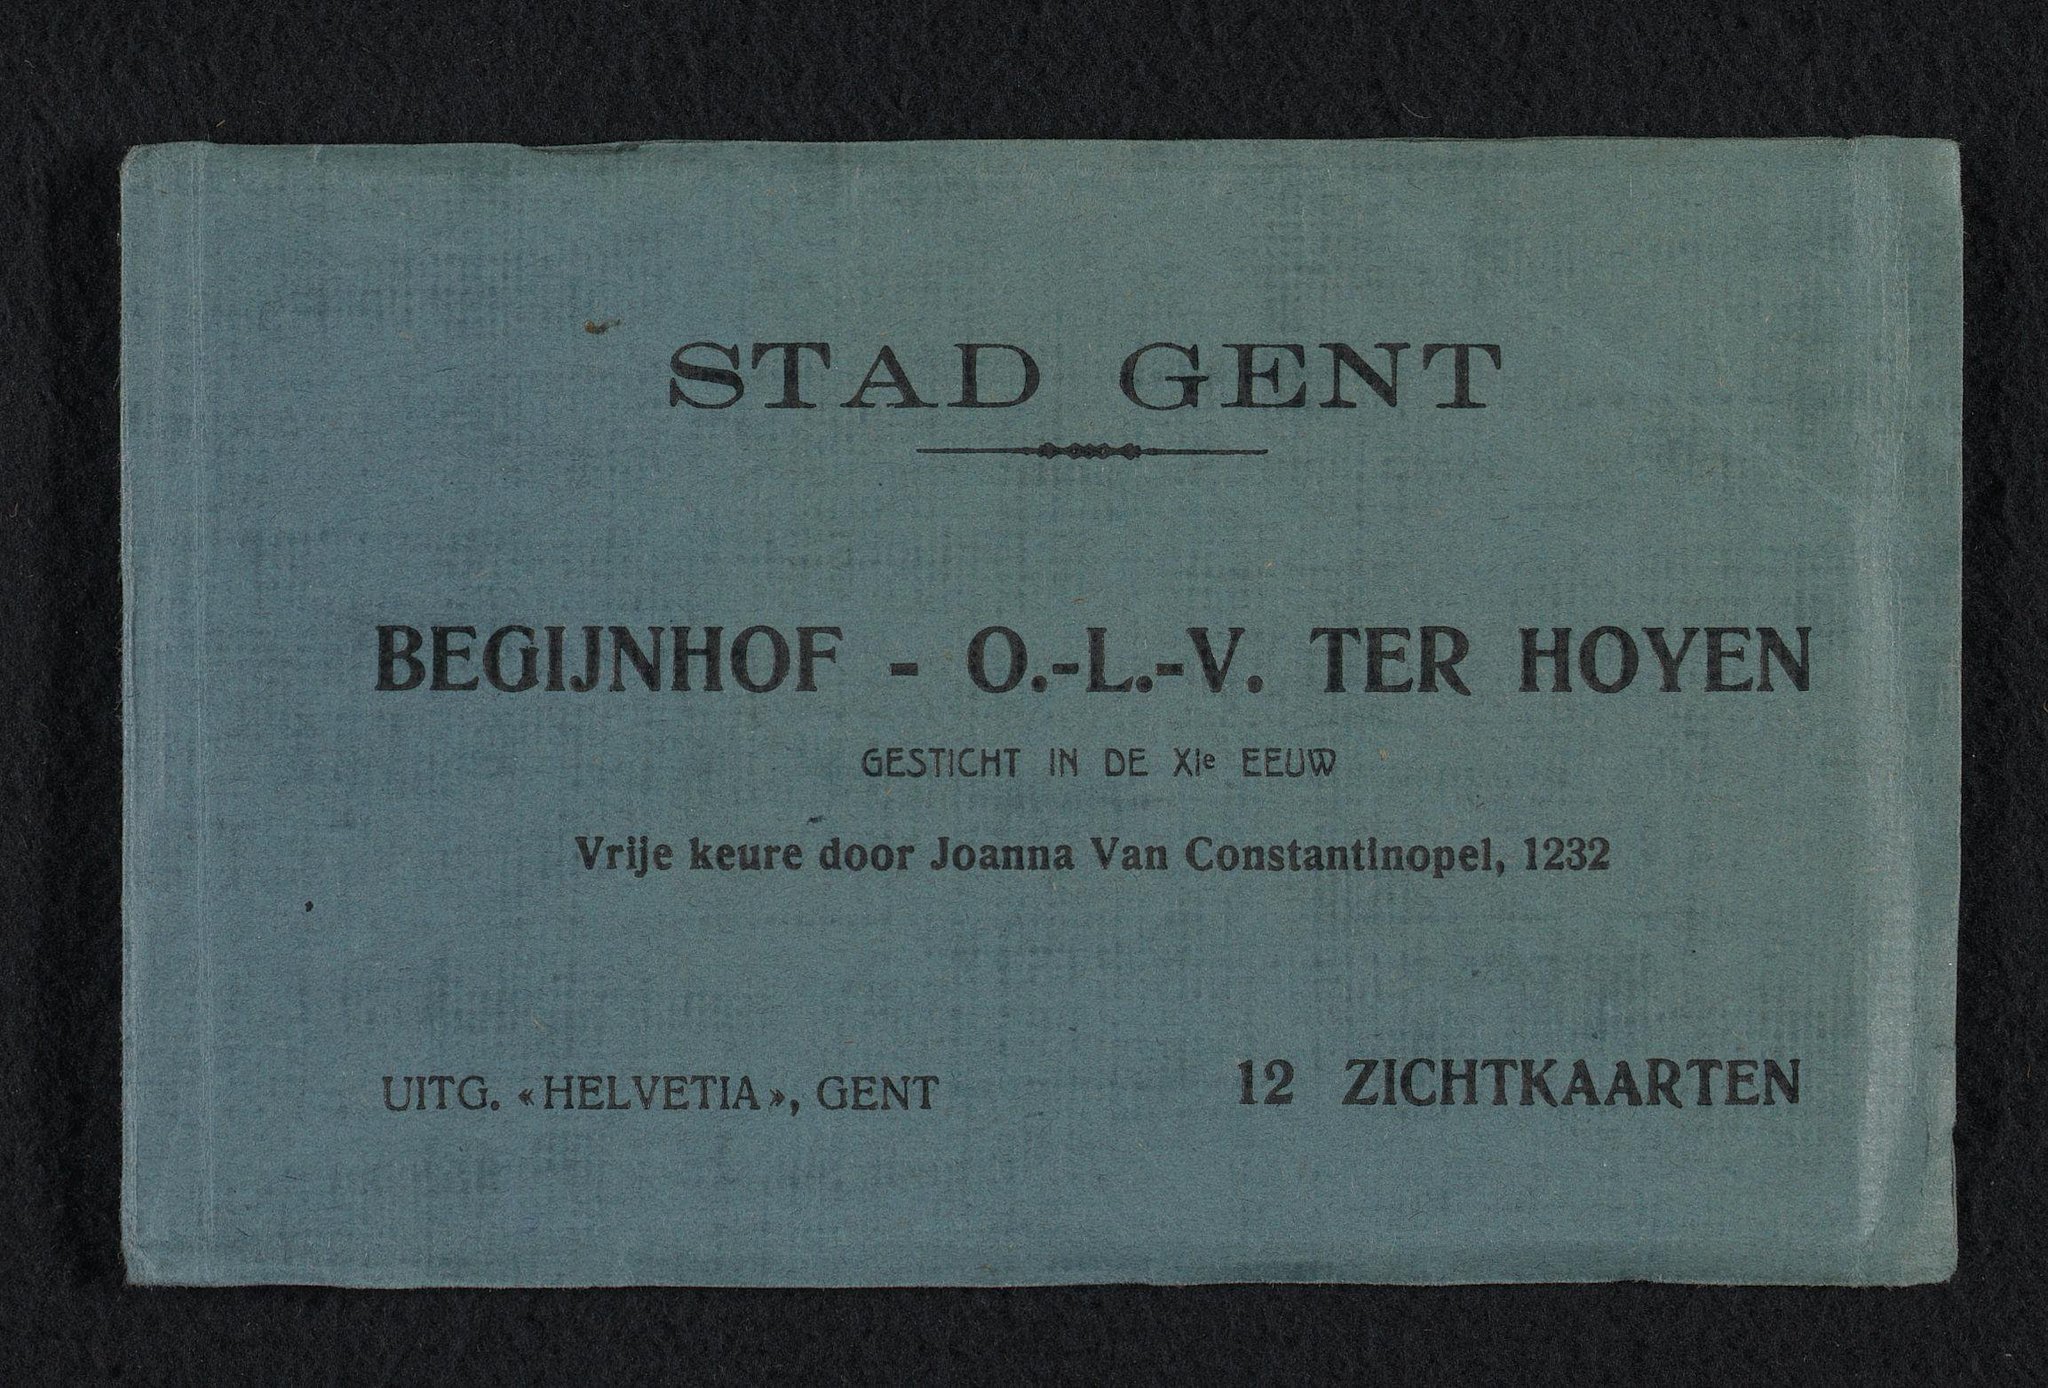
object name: album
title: Album met voorstellingen van een begijnhof te Gent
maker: Anonymous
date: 1906-1915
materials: cardboard, paper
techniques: photograph, letterpress printing, stapling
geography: ghent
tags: urban housing, church (exterior), the worship of god, ghent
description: Album met twaalf prentbriefkaarten van Gent. De prentbriefkaarten kunnen eruit gescheurd worden.